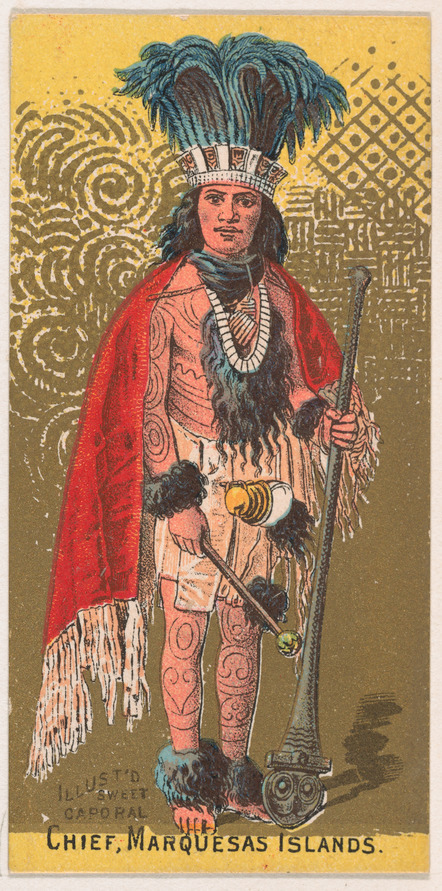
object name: print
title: Chief, Marquesas Islands, from the Military Series (N224) issued by Kinney Tobacco Company to promote Sweet Caporal Cigarettes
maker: kinney brothers tobacco company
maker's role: publisher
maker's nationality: american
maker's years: 1869-2011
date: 1888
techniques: color lithograph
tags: military,weapons,men